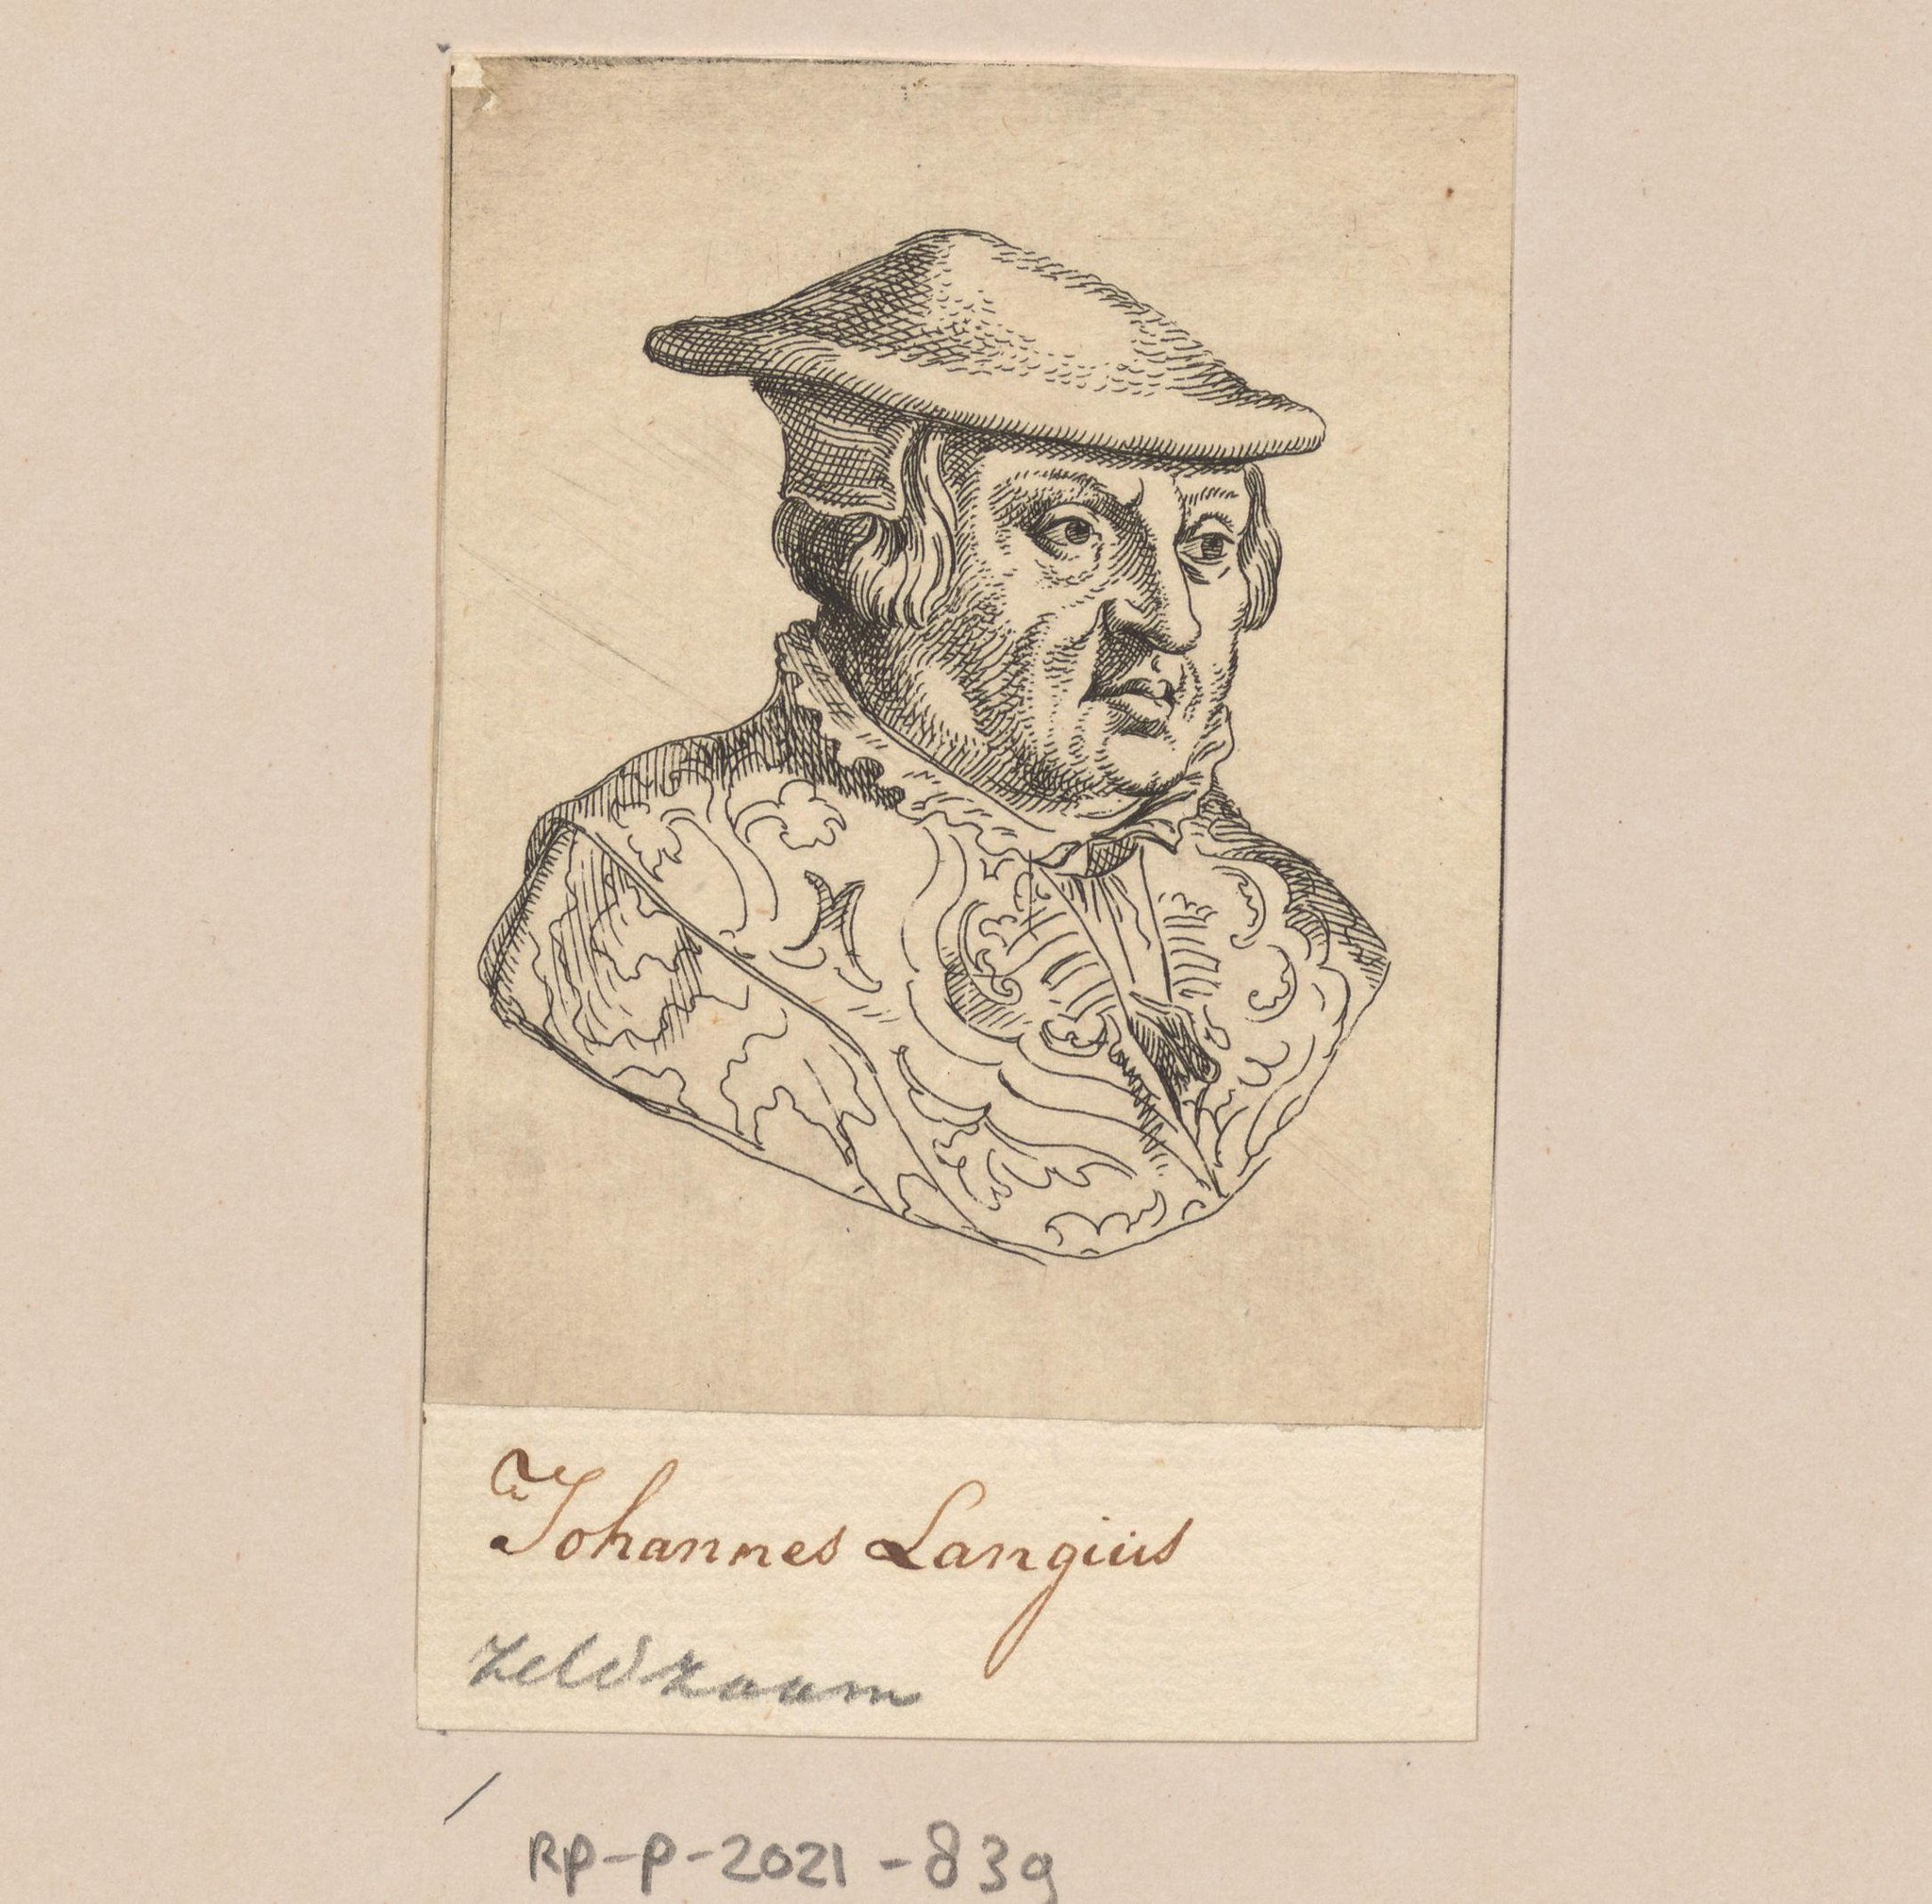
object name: print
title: Portret van Johannes Lange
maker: Anonymous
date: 1600-1699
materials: paper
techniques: etching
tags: historical persons, physician, doctor (+ portrait of scholar, scientist)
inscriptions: inscription: ‘Johannes Langius’, inscription: ‘zeldzaam’